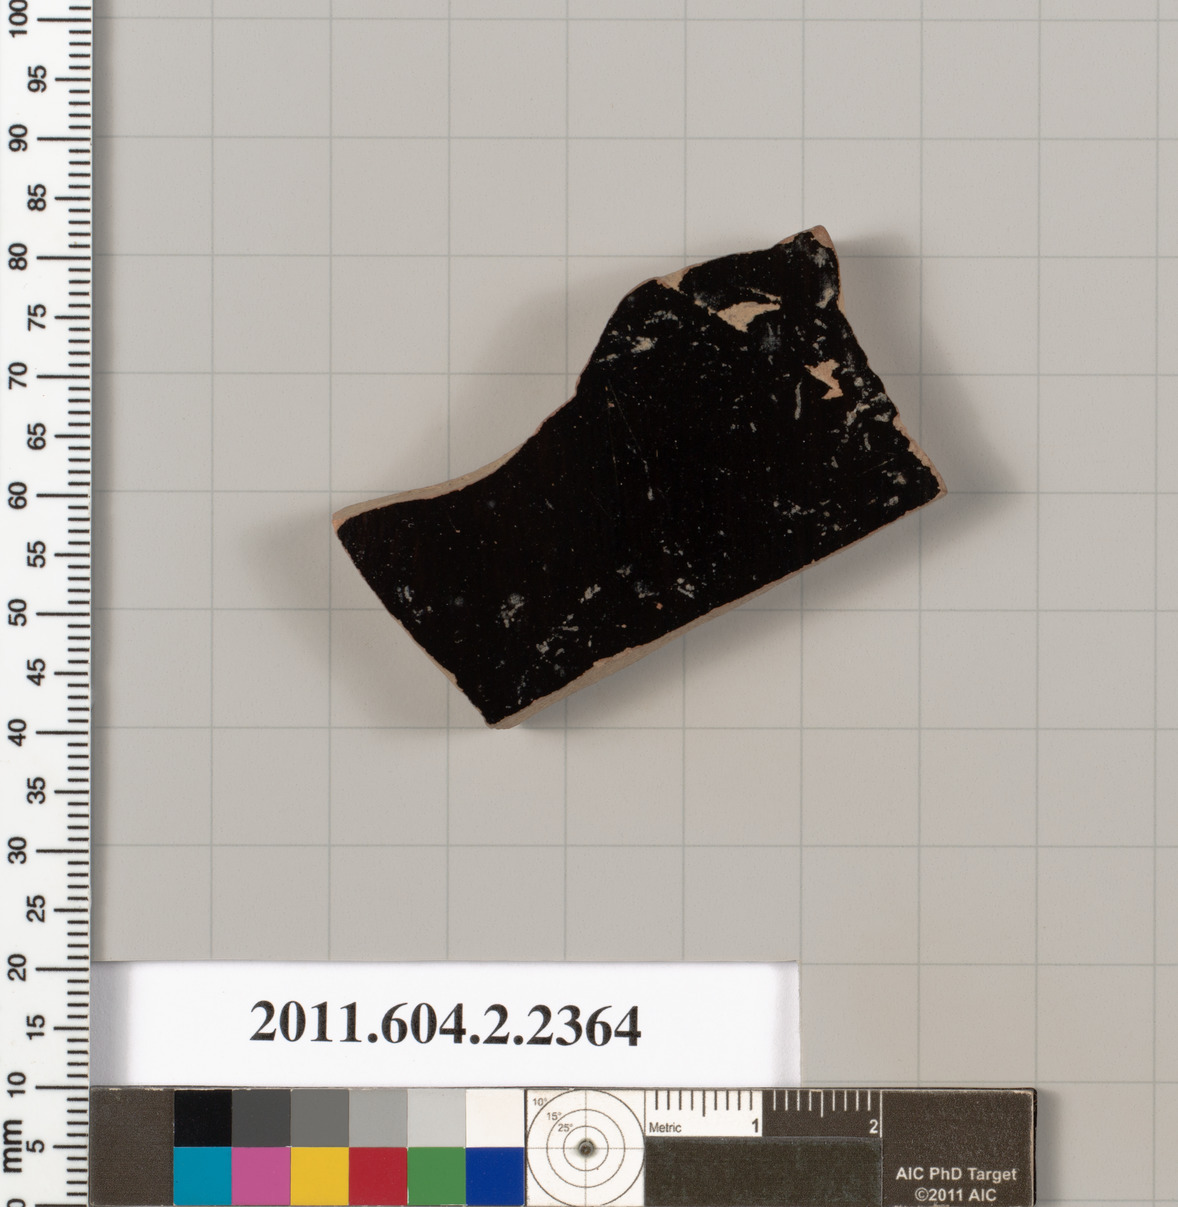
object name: pot fragment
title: Terracotta fragment of a pot; unglazed on the inside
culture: greek, attic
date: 600-401 BCE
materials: terracotta